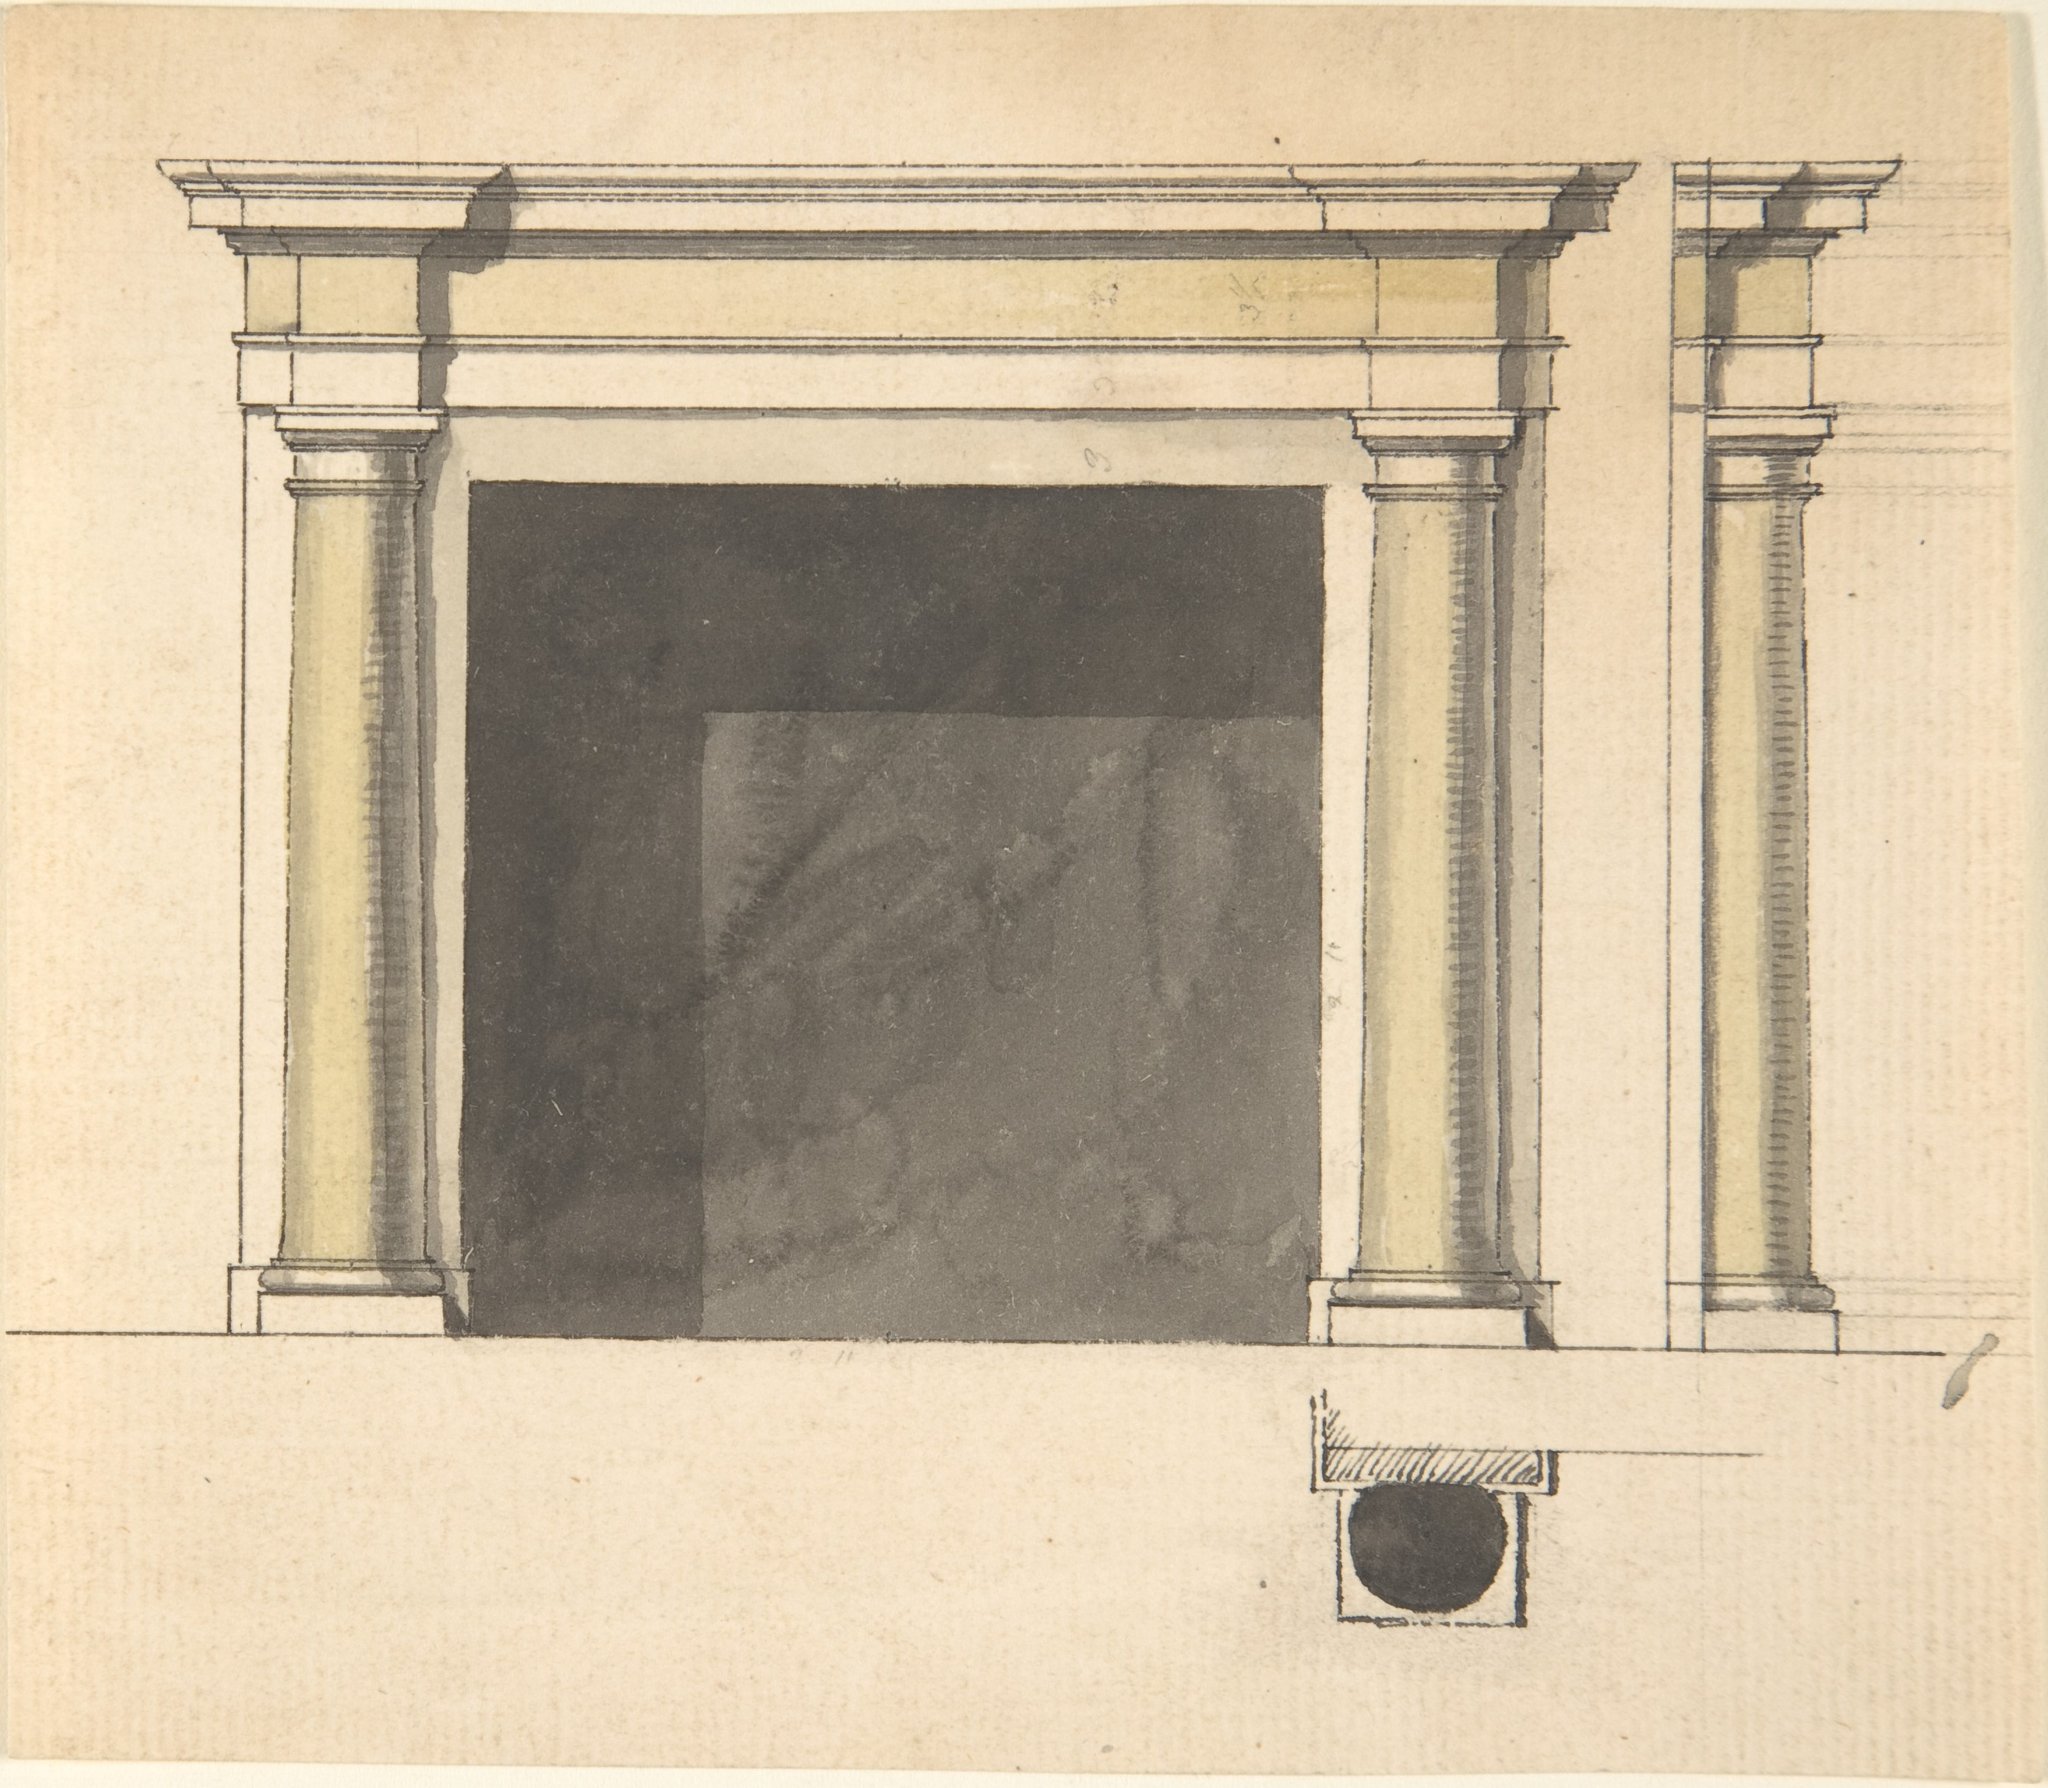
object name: drawing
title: Design for a Chimneypiece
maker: sir william chambers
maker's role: artist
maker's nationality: british, born sweden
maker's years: 1723-1796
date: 1740-1800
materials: ink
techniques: brush, pen, wash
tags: architecture,fireplaces